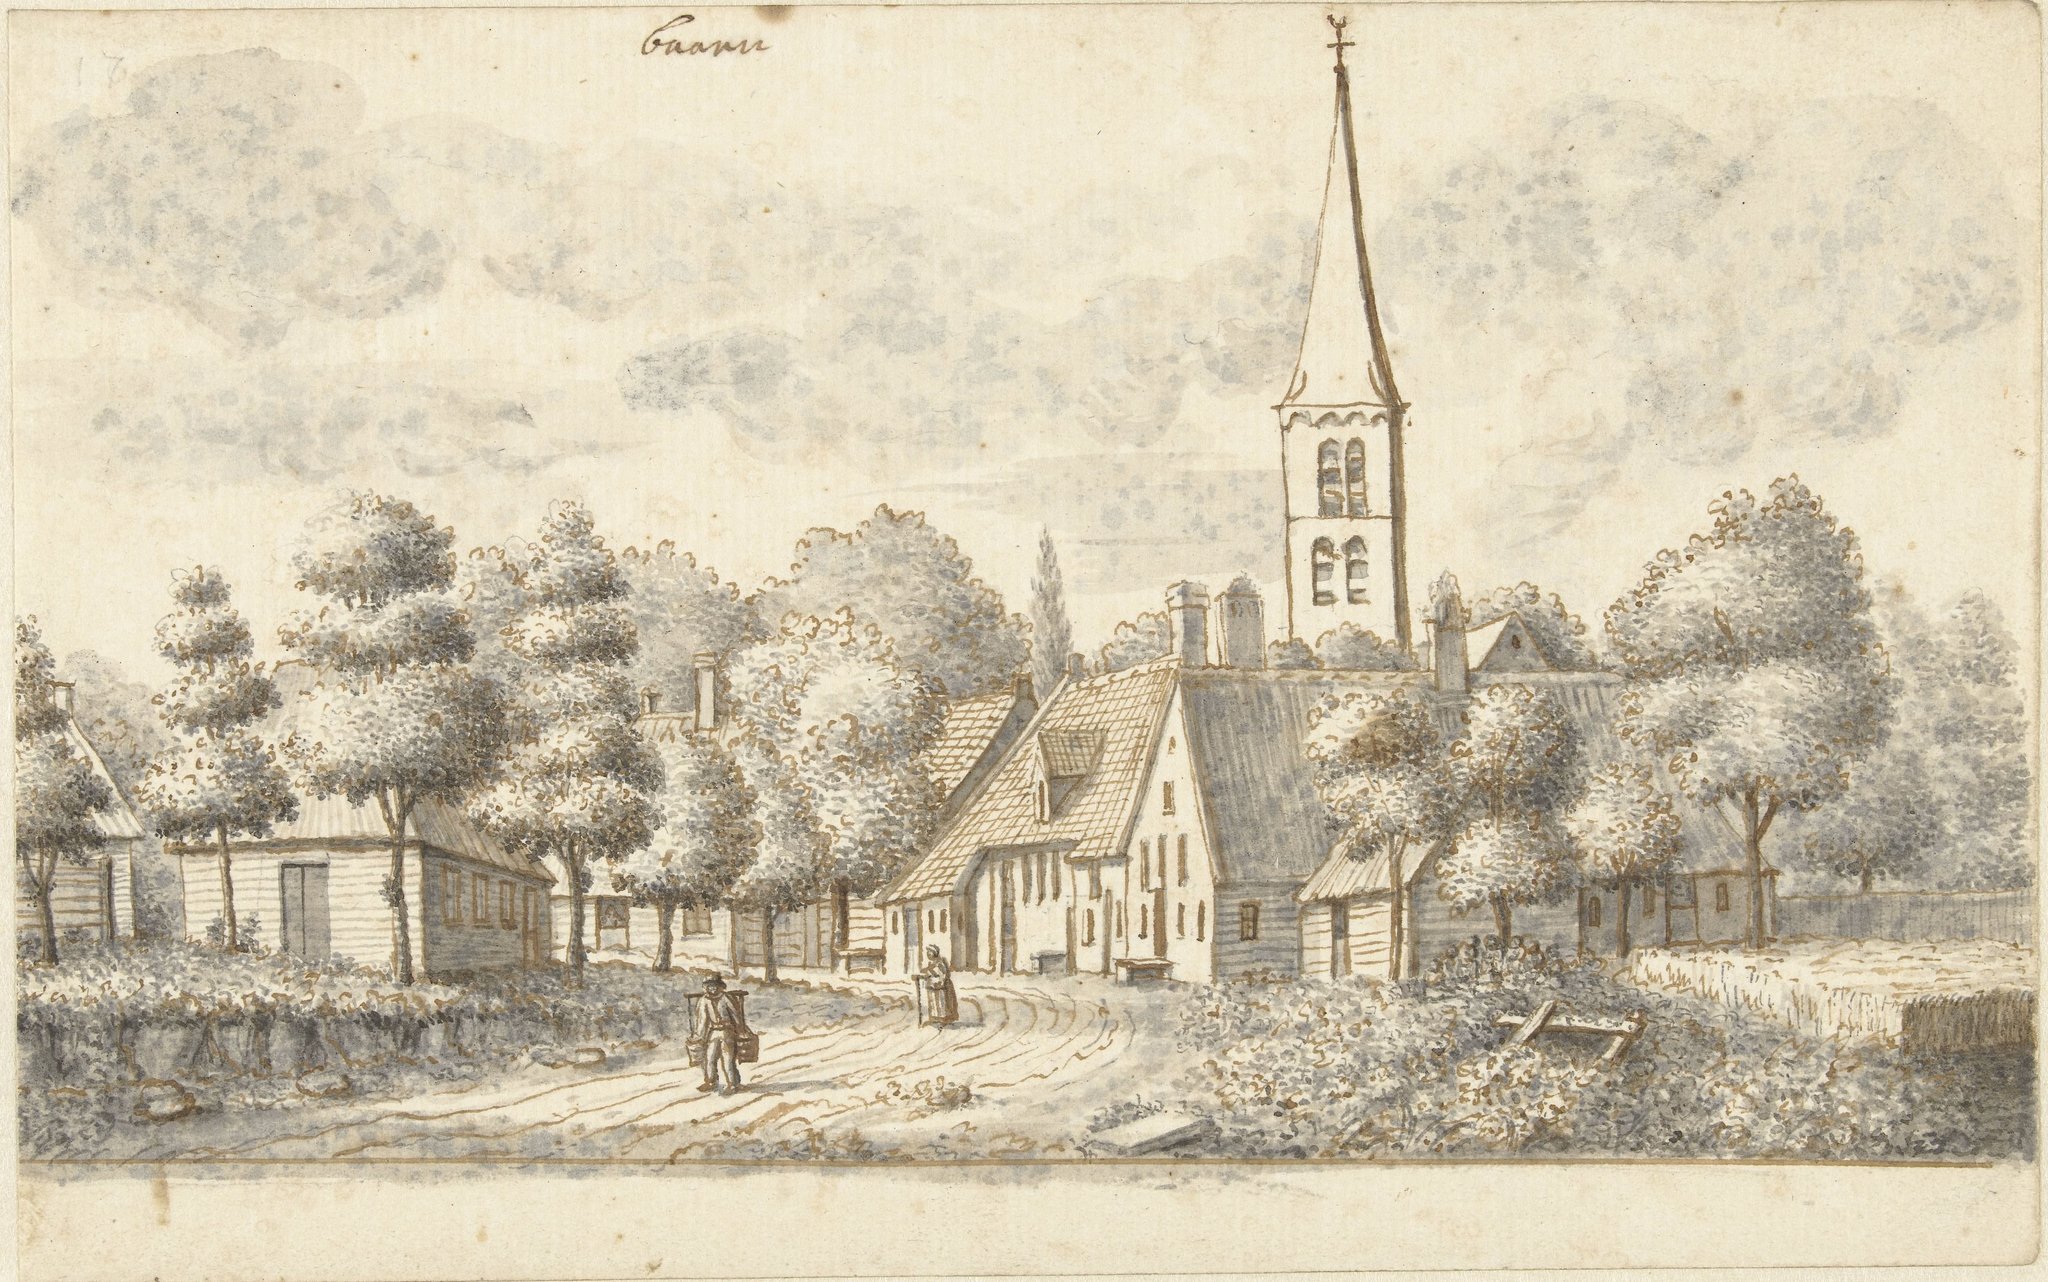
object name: drawing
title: Het dorp Hondsbos bij Petten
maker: joseph adolf schmetterling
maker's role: draughtsman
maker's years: 1751-1828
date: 1761-1828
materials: ink, paper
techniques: brush, pen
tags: hondsbos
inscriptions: inscription: ‘Hondsbosch in Kennemerland by Petten / den Hondsbosch’